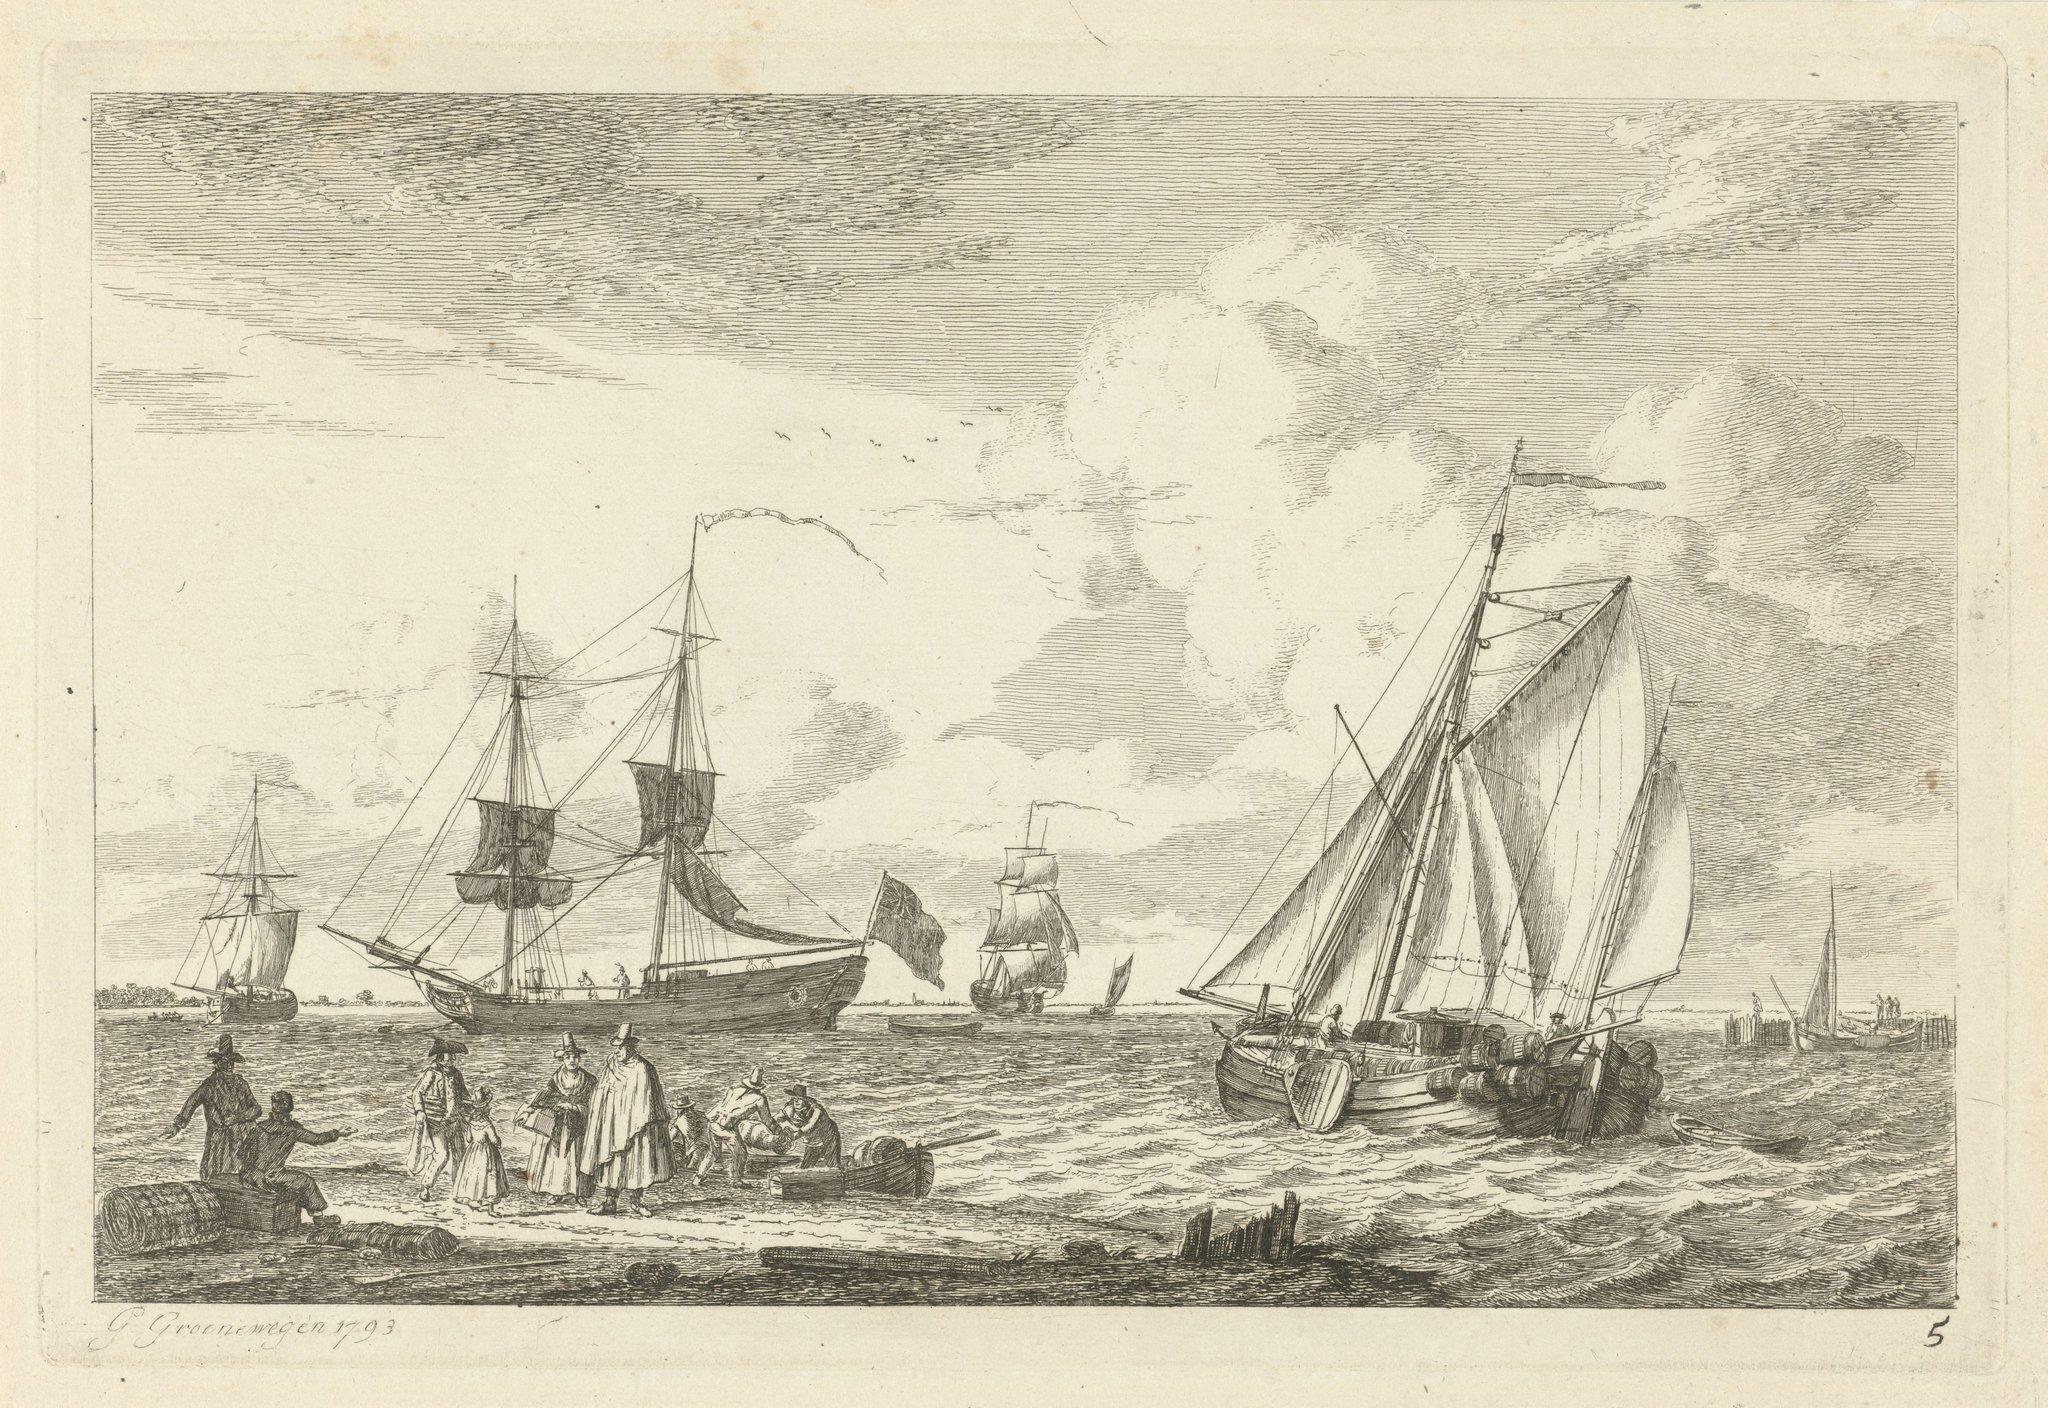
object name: print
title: Diverse schepen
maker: gerrit groenewegen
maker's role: draughtsman, print maker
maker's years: 1754-1826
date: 1793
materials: paper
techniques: etching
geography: rotterdam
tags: ships (in general)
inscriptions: collector's mark: Lugt 2228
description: Zeegezicht met diverse zeilschepen en sloepen. Links op de voorgrond negen figuren, waarvan er drie spullen uit een sloep aan land brengen. Deze prent maakt deel uit van een serie van vijf prenten met verschillende schepen op open water. Rechts in de marge: 5.